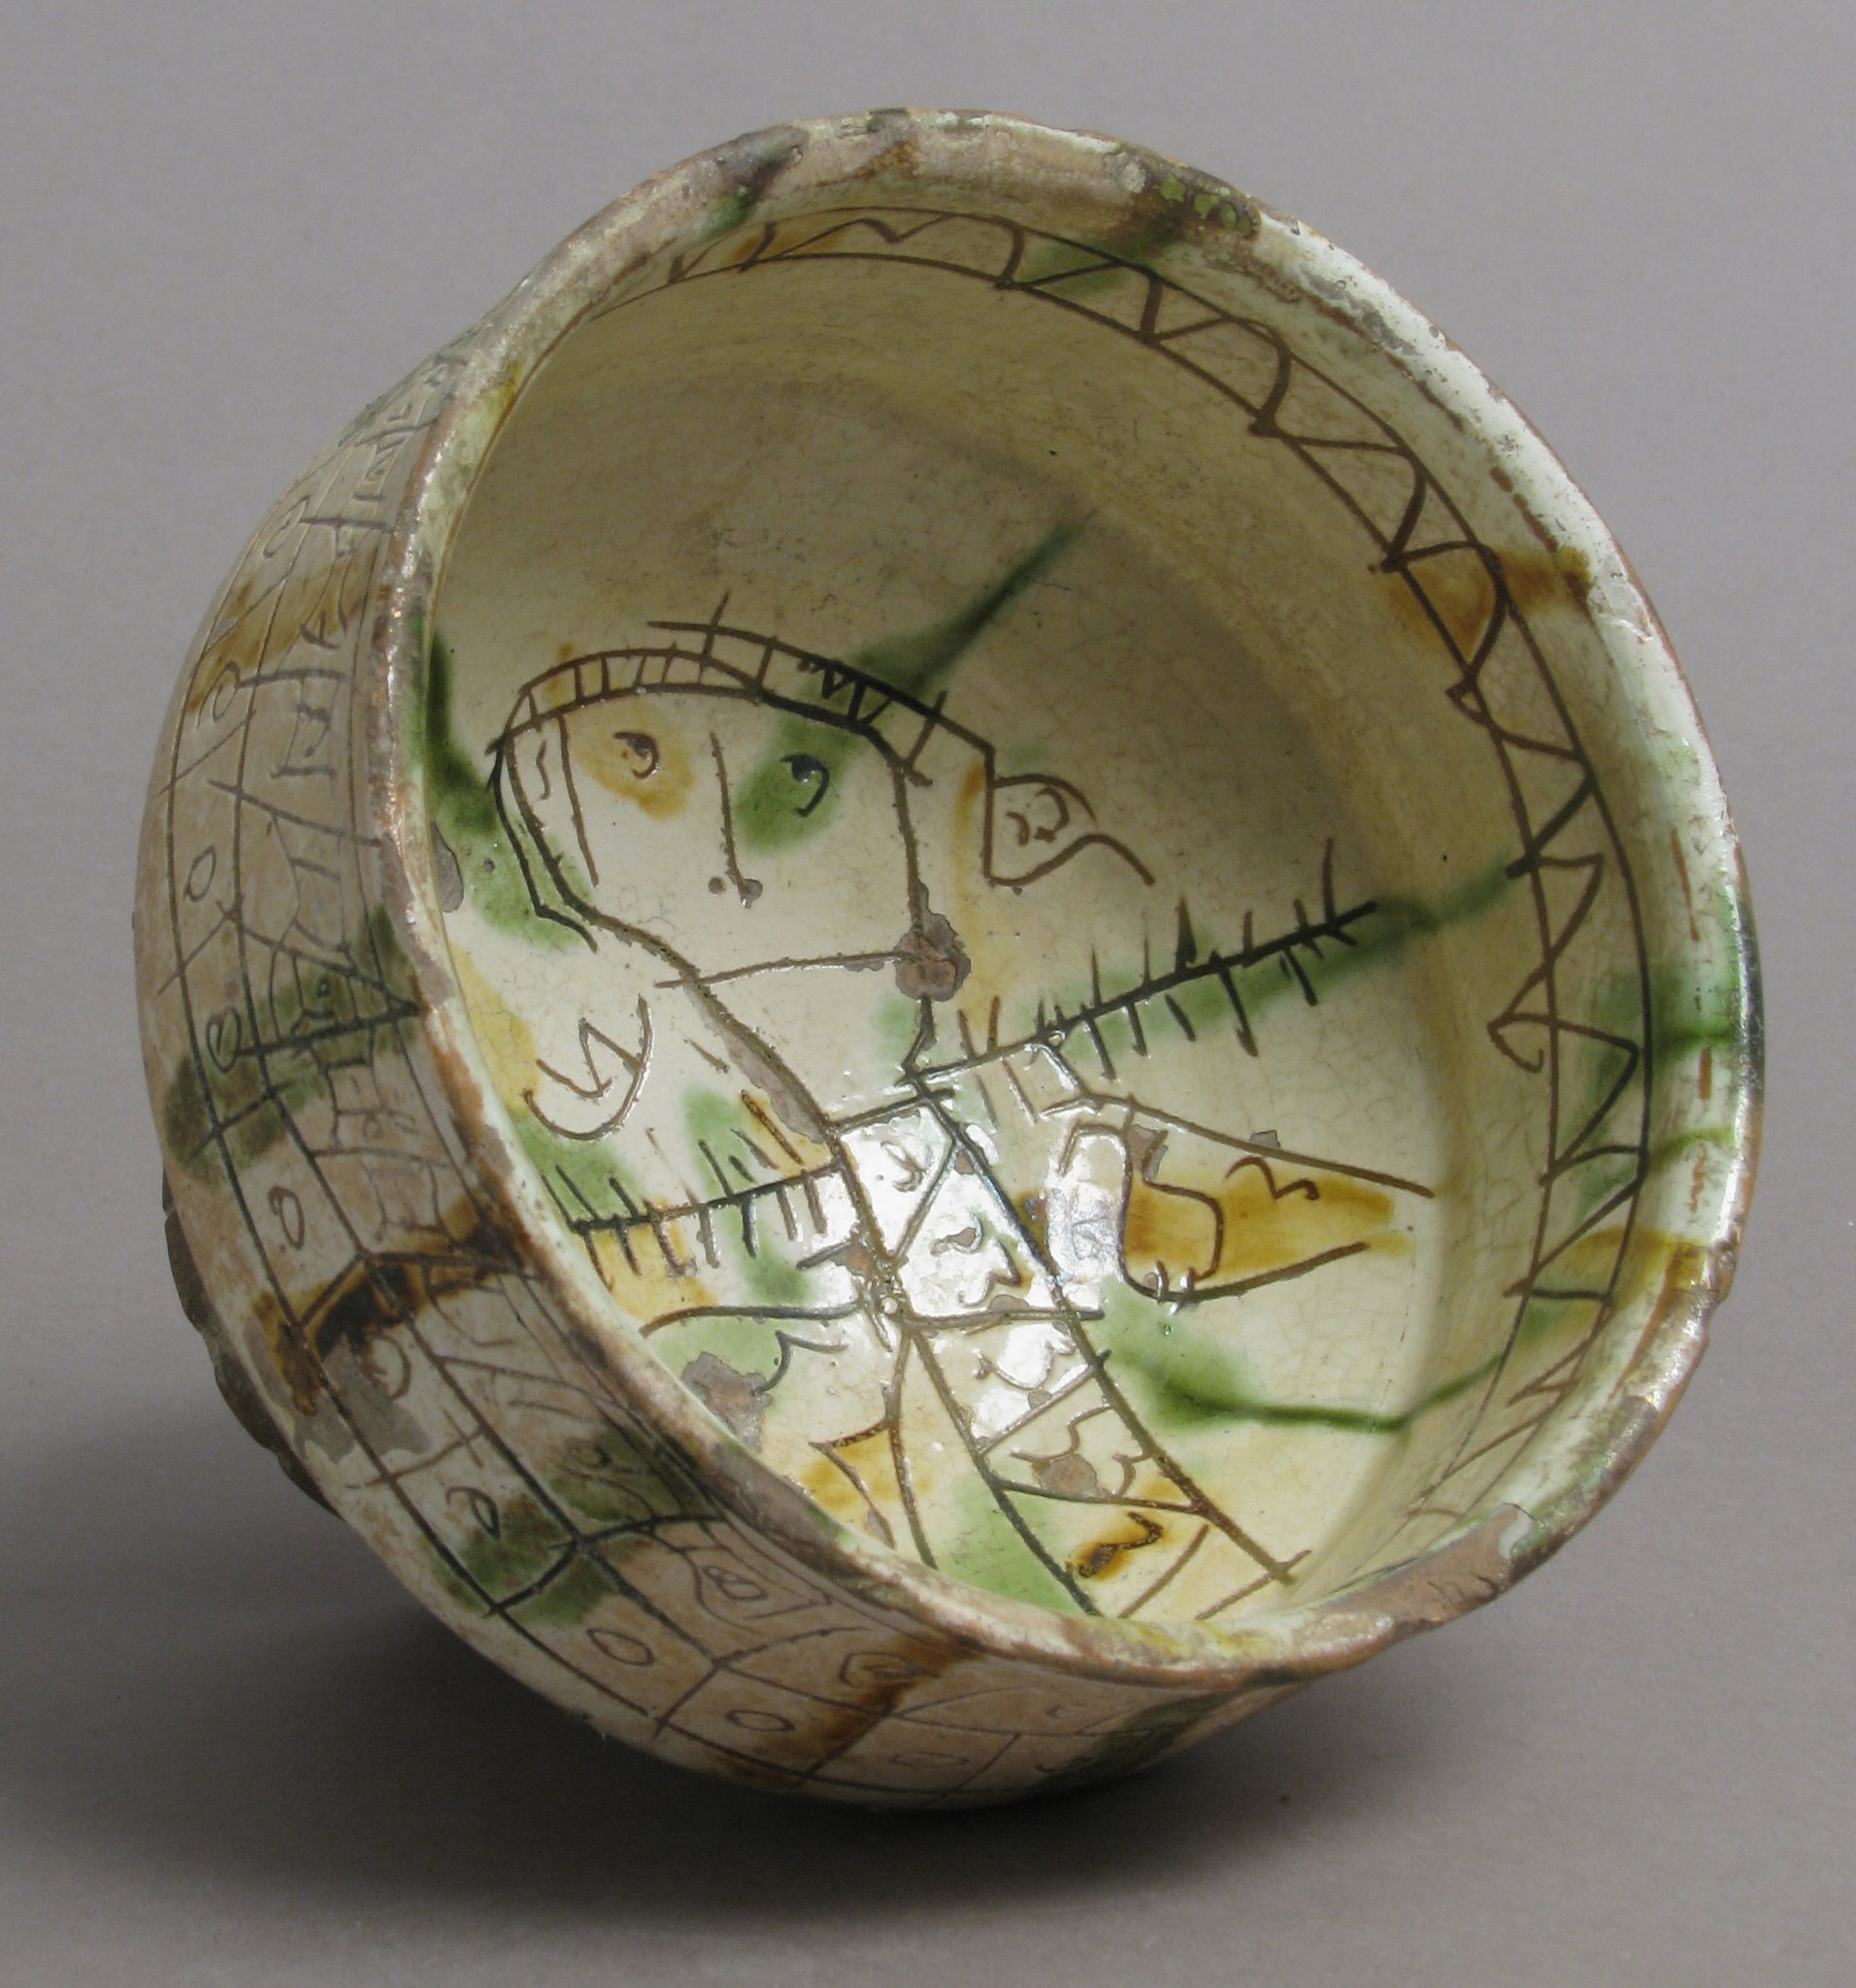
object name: bowl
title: Footed Cup with Falconer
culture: byzantine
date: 1401-1500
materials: earthenware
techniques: glazing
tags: men